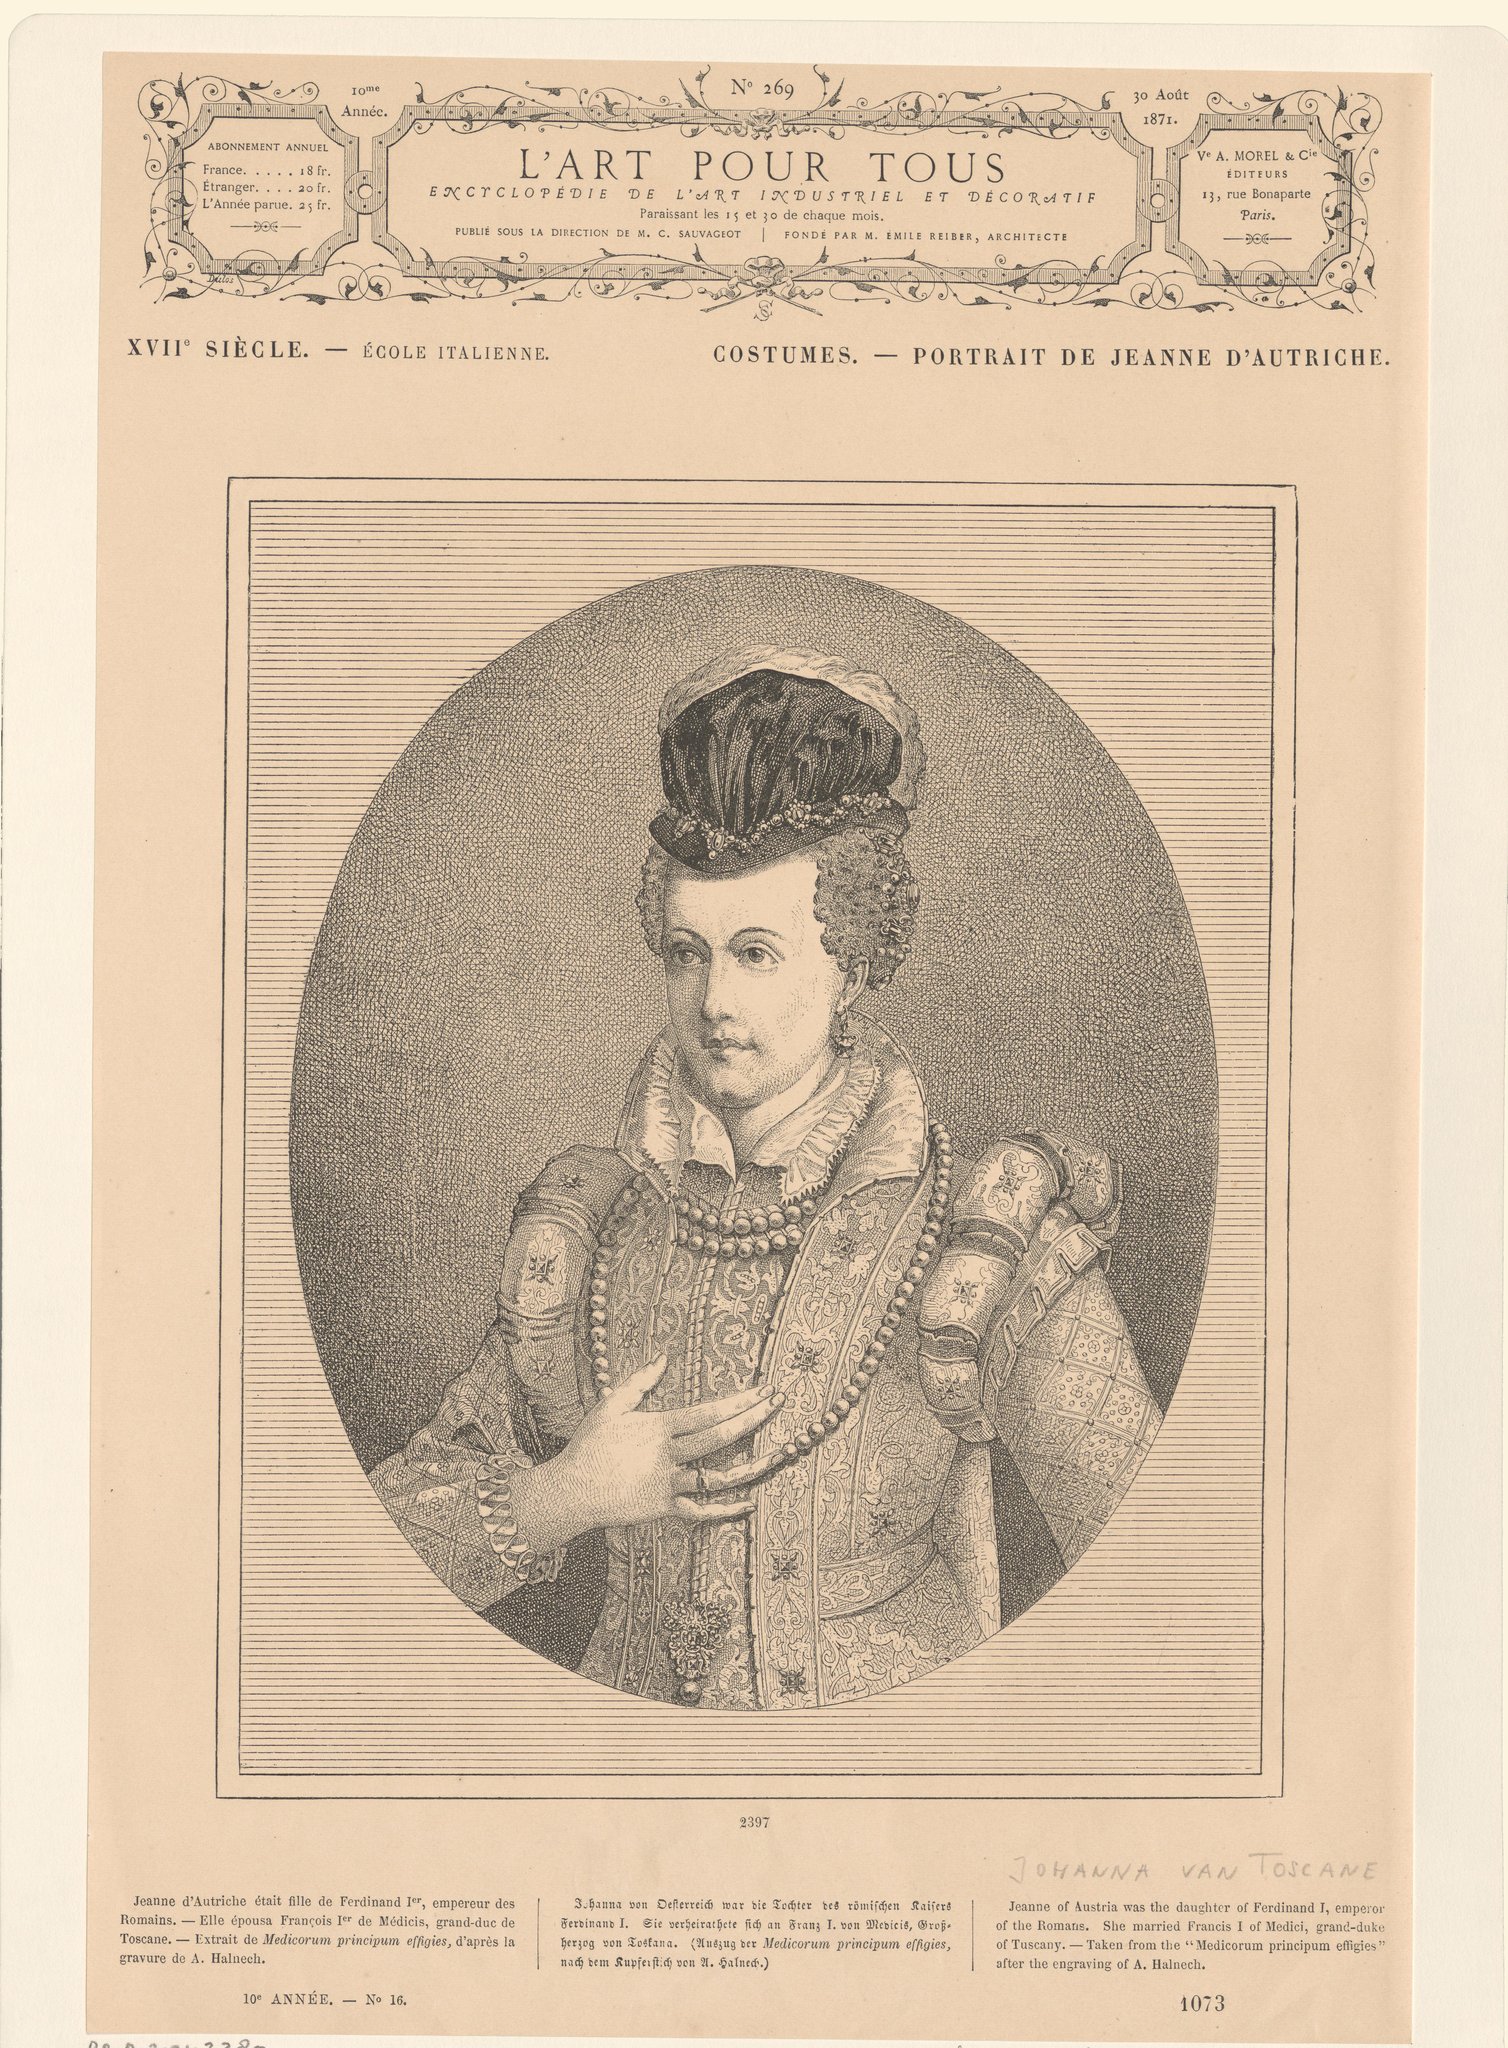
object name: photomechanical print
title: Portret van Johanna van Oostenrijk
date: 1871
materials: paper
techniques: letterpress printing, printing block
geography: paris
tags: prague, historical persons - bb - woman, nobility and patriciate; chivalry, knighthood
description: Prent uit: L'Art pour tous 10 (1871), nr. 269, 30 augustus 1871.